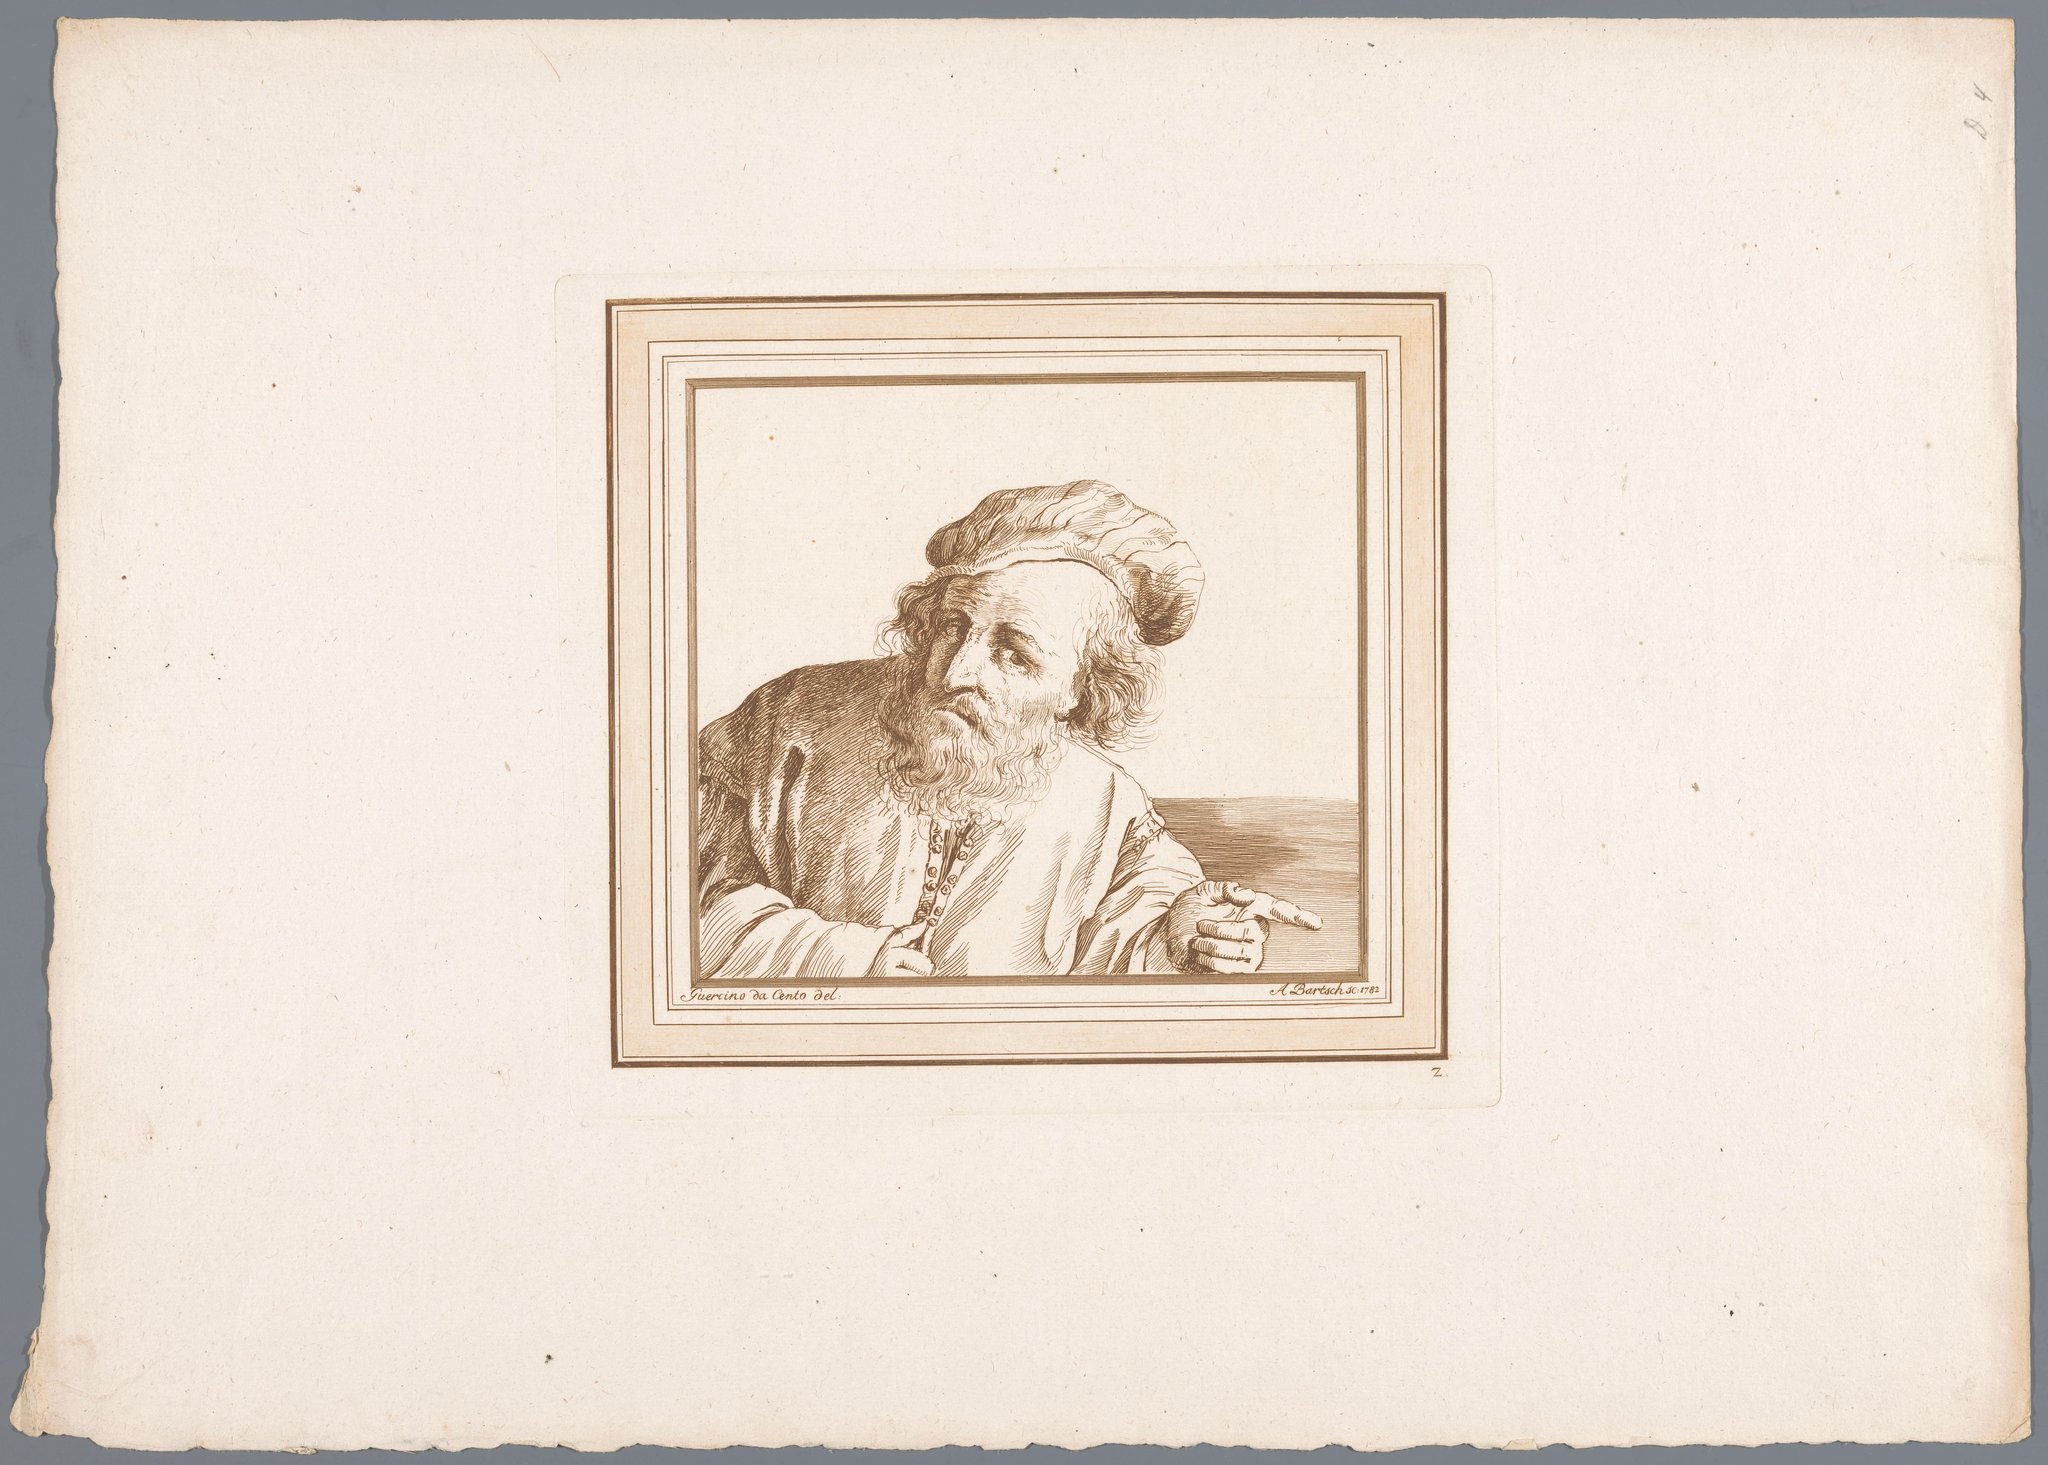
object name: print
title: Buste van een oude man, wijzend naar rechts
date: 1782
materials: paper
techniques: etching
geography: italy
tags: head-gear: beret, beard, index finger forwards, pointing, indicating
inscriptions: collector's mark: Lugt 2228